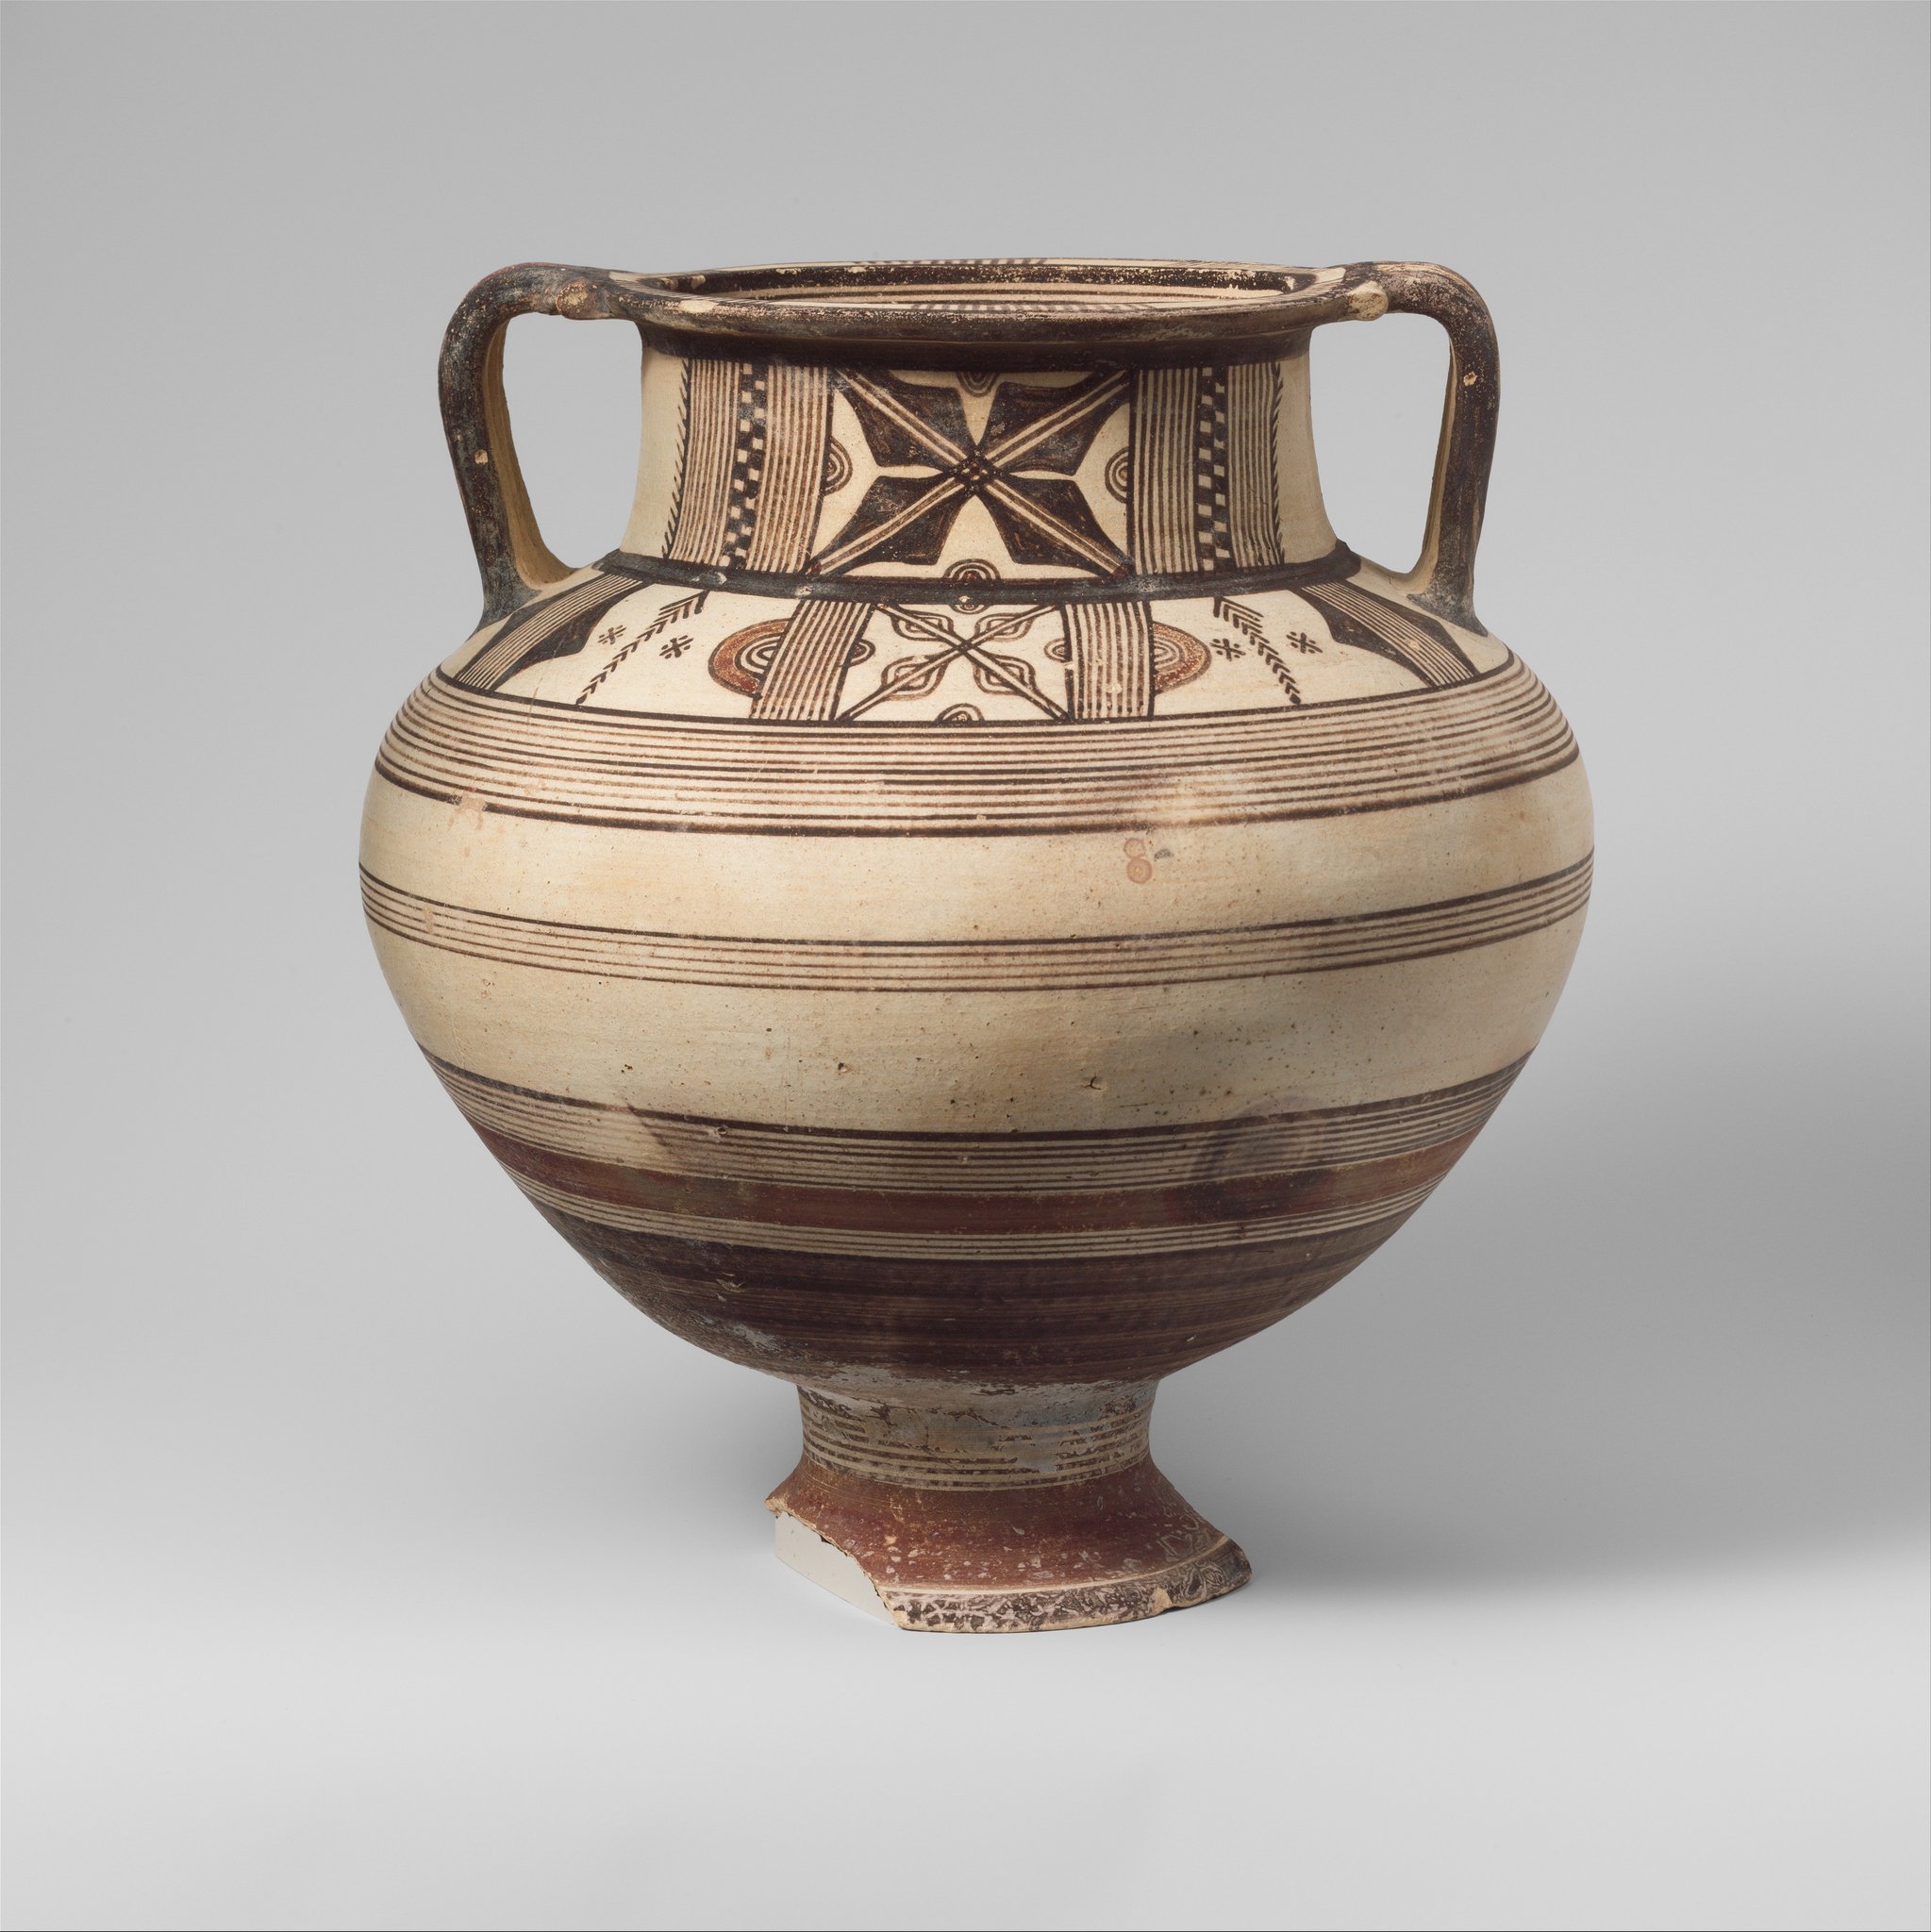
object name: amphora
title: Terracotta amphora (jar)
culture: cypriot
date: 850-750 BCE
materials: terracotta